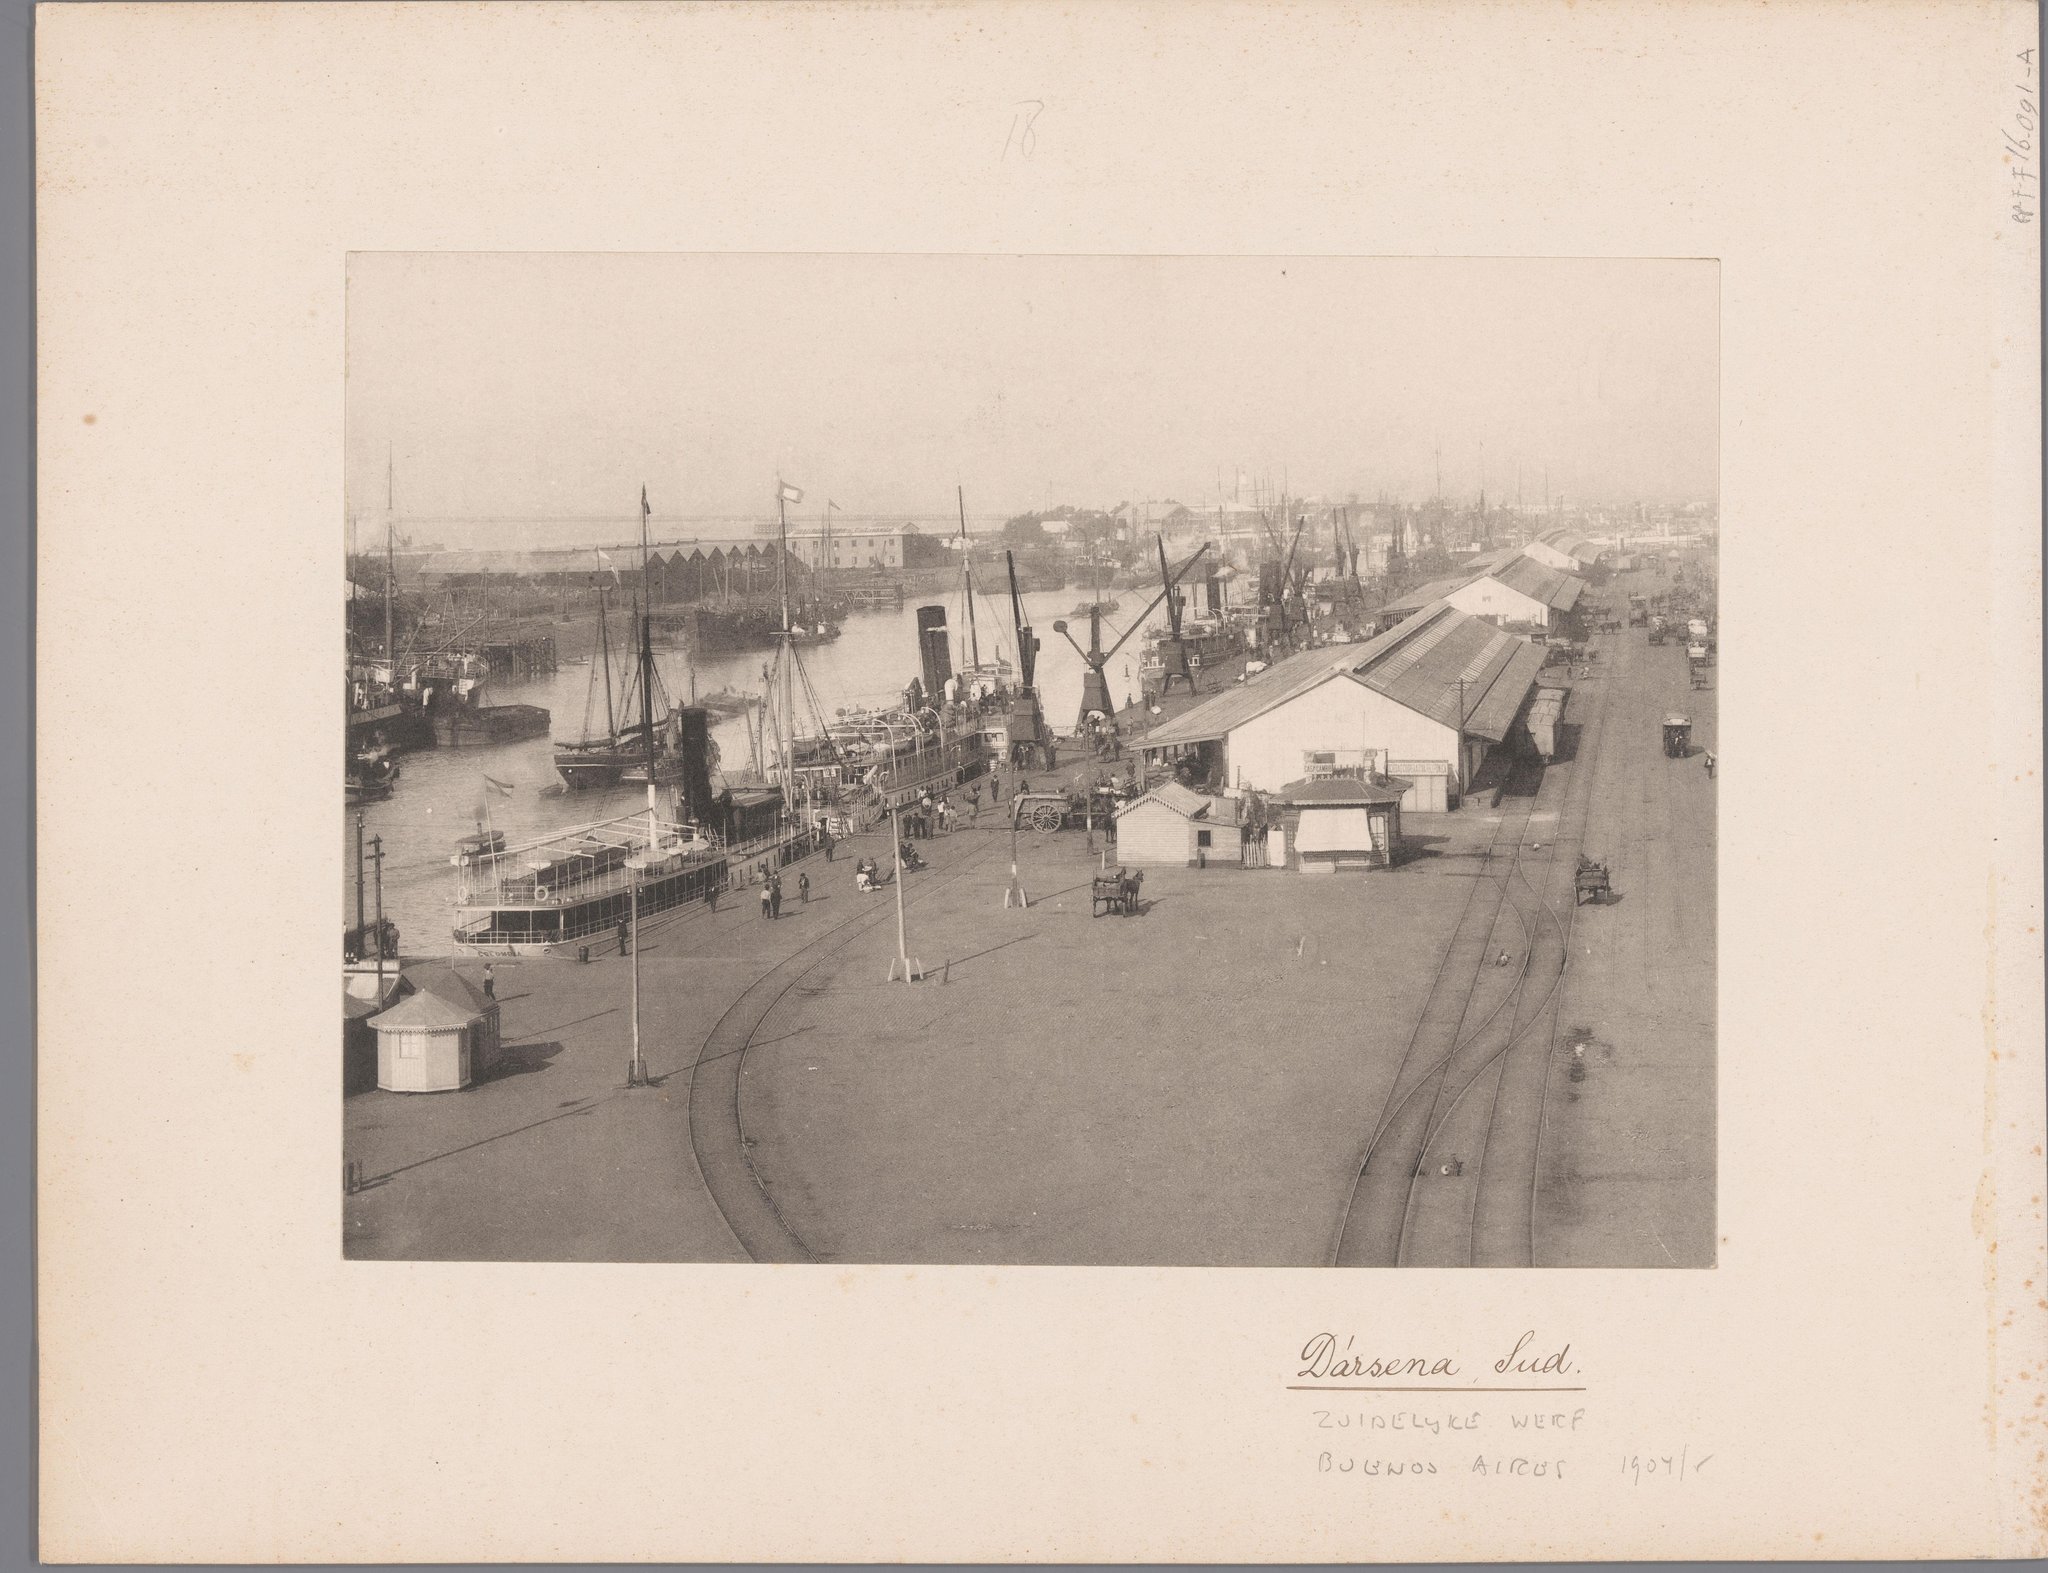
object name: photomechanical print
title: Zuidelijke scheepswerf in Buenos Aires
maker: Anonymous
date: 1904-1905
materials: cardboard, paper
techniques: photograph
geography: buenos aires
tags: harbour